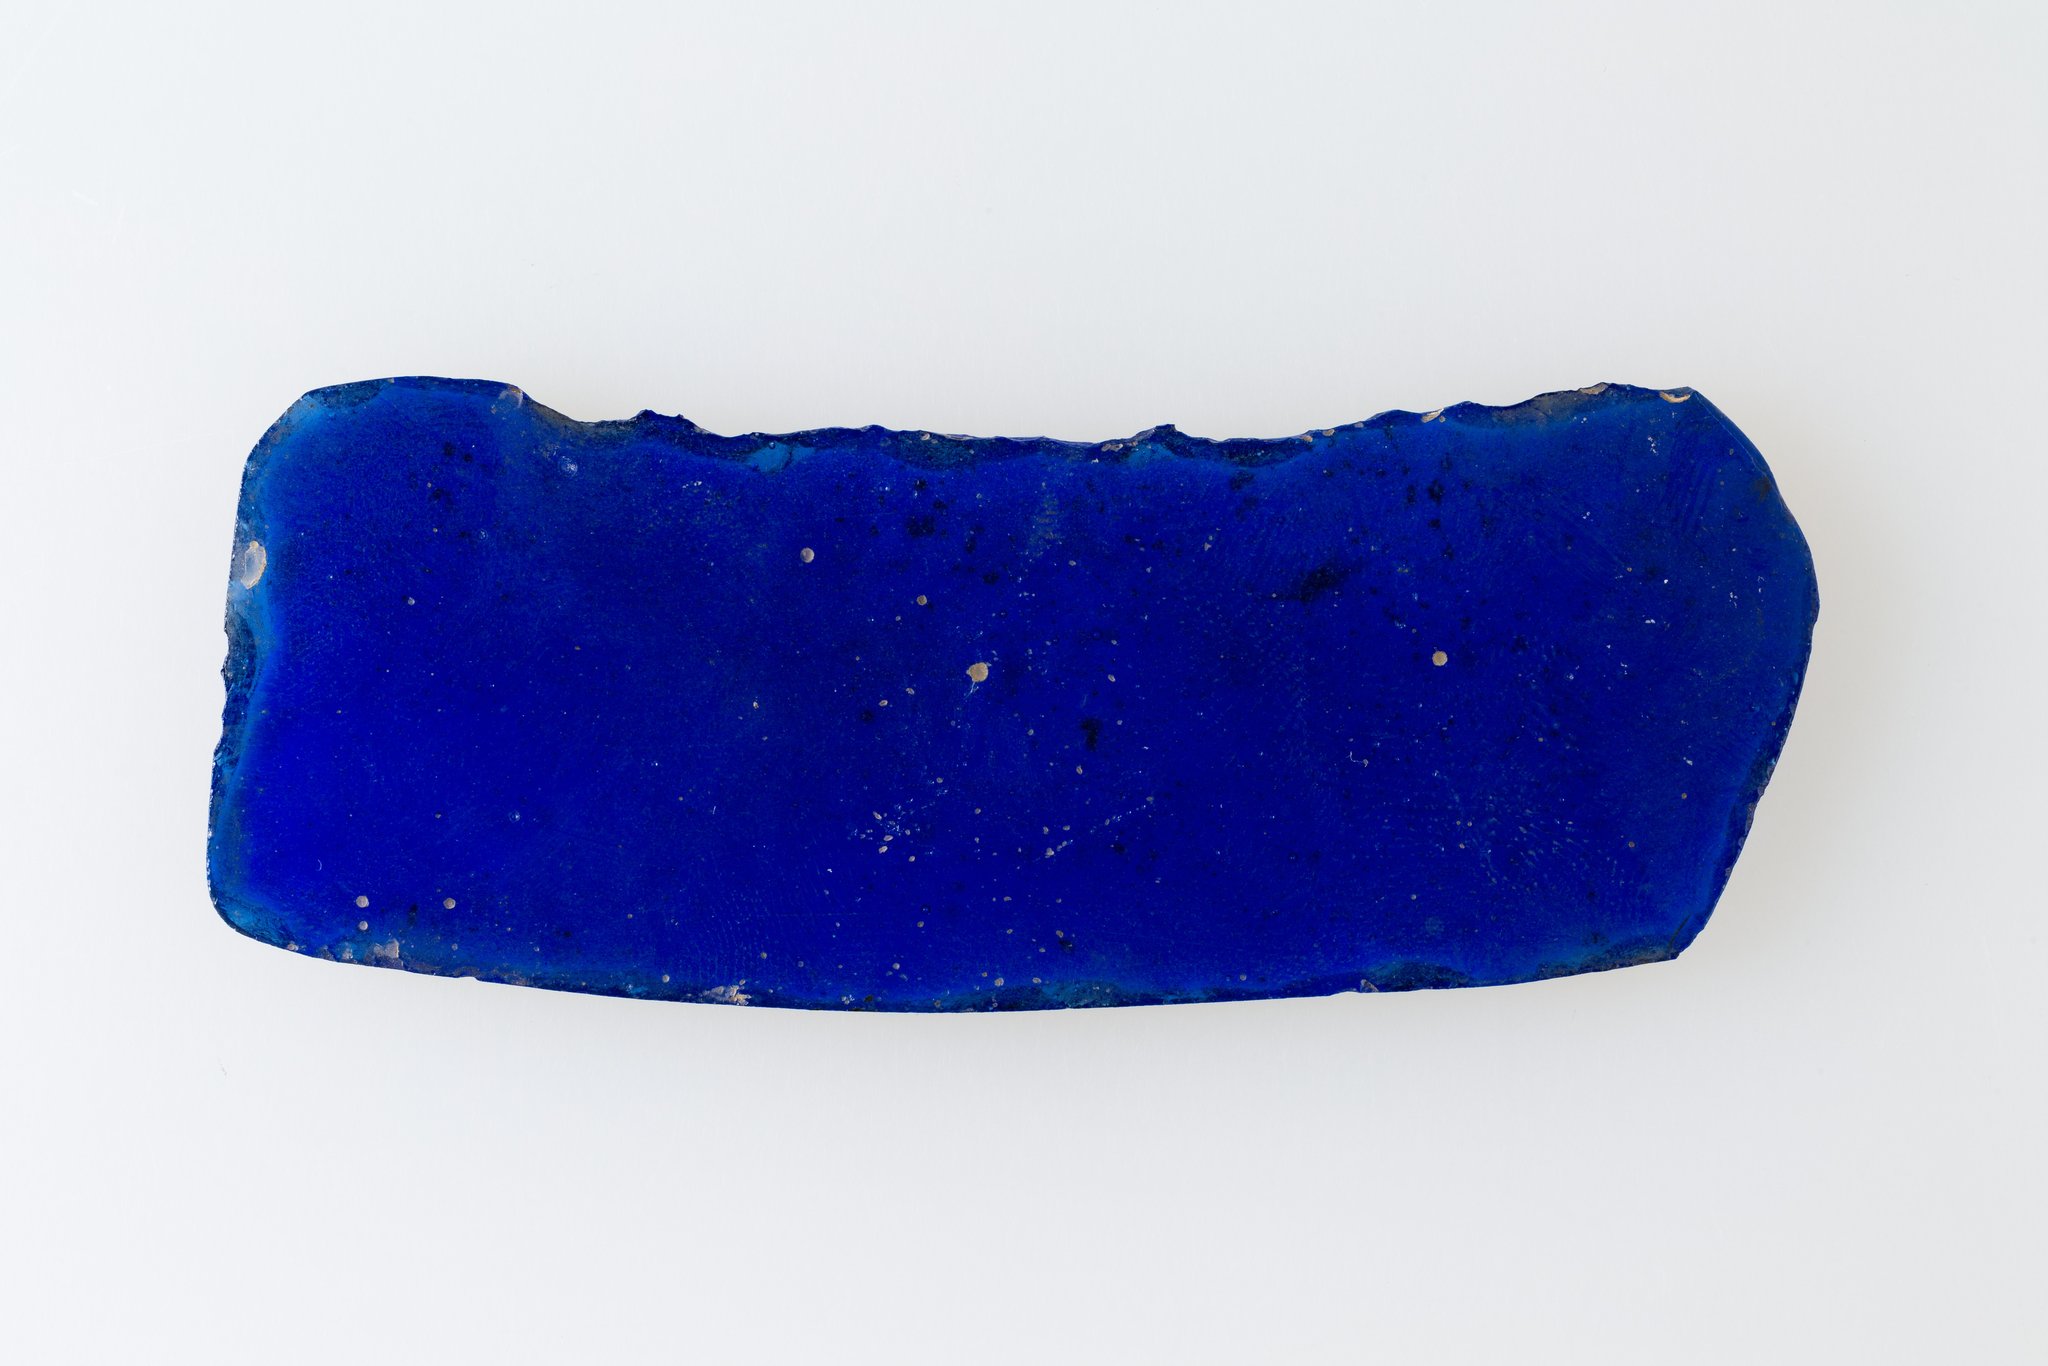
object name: inlay fragment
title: Wall revetment, marble pattern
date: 200 BCE-100 CE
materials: glass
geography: egypt